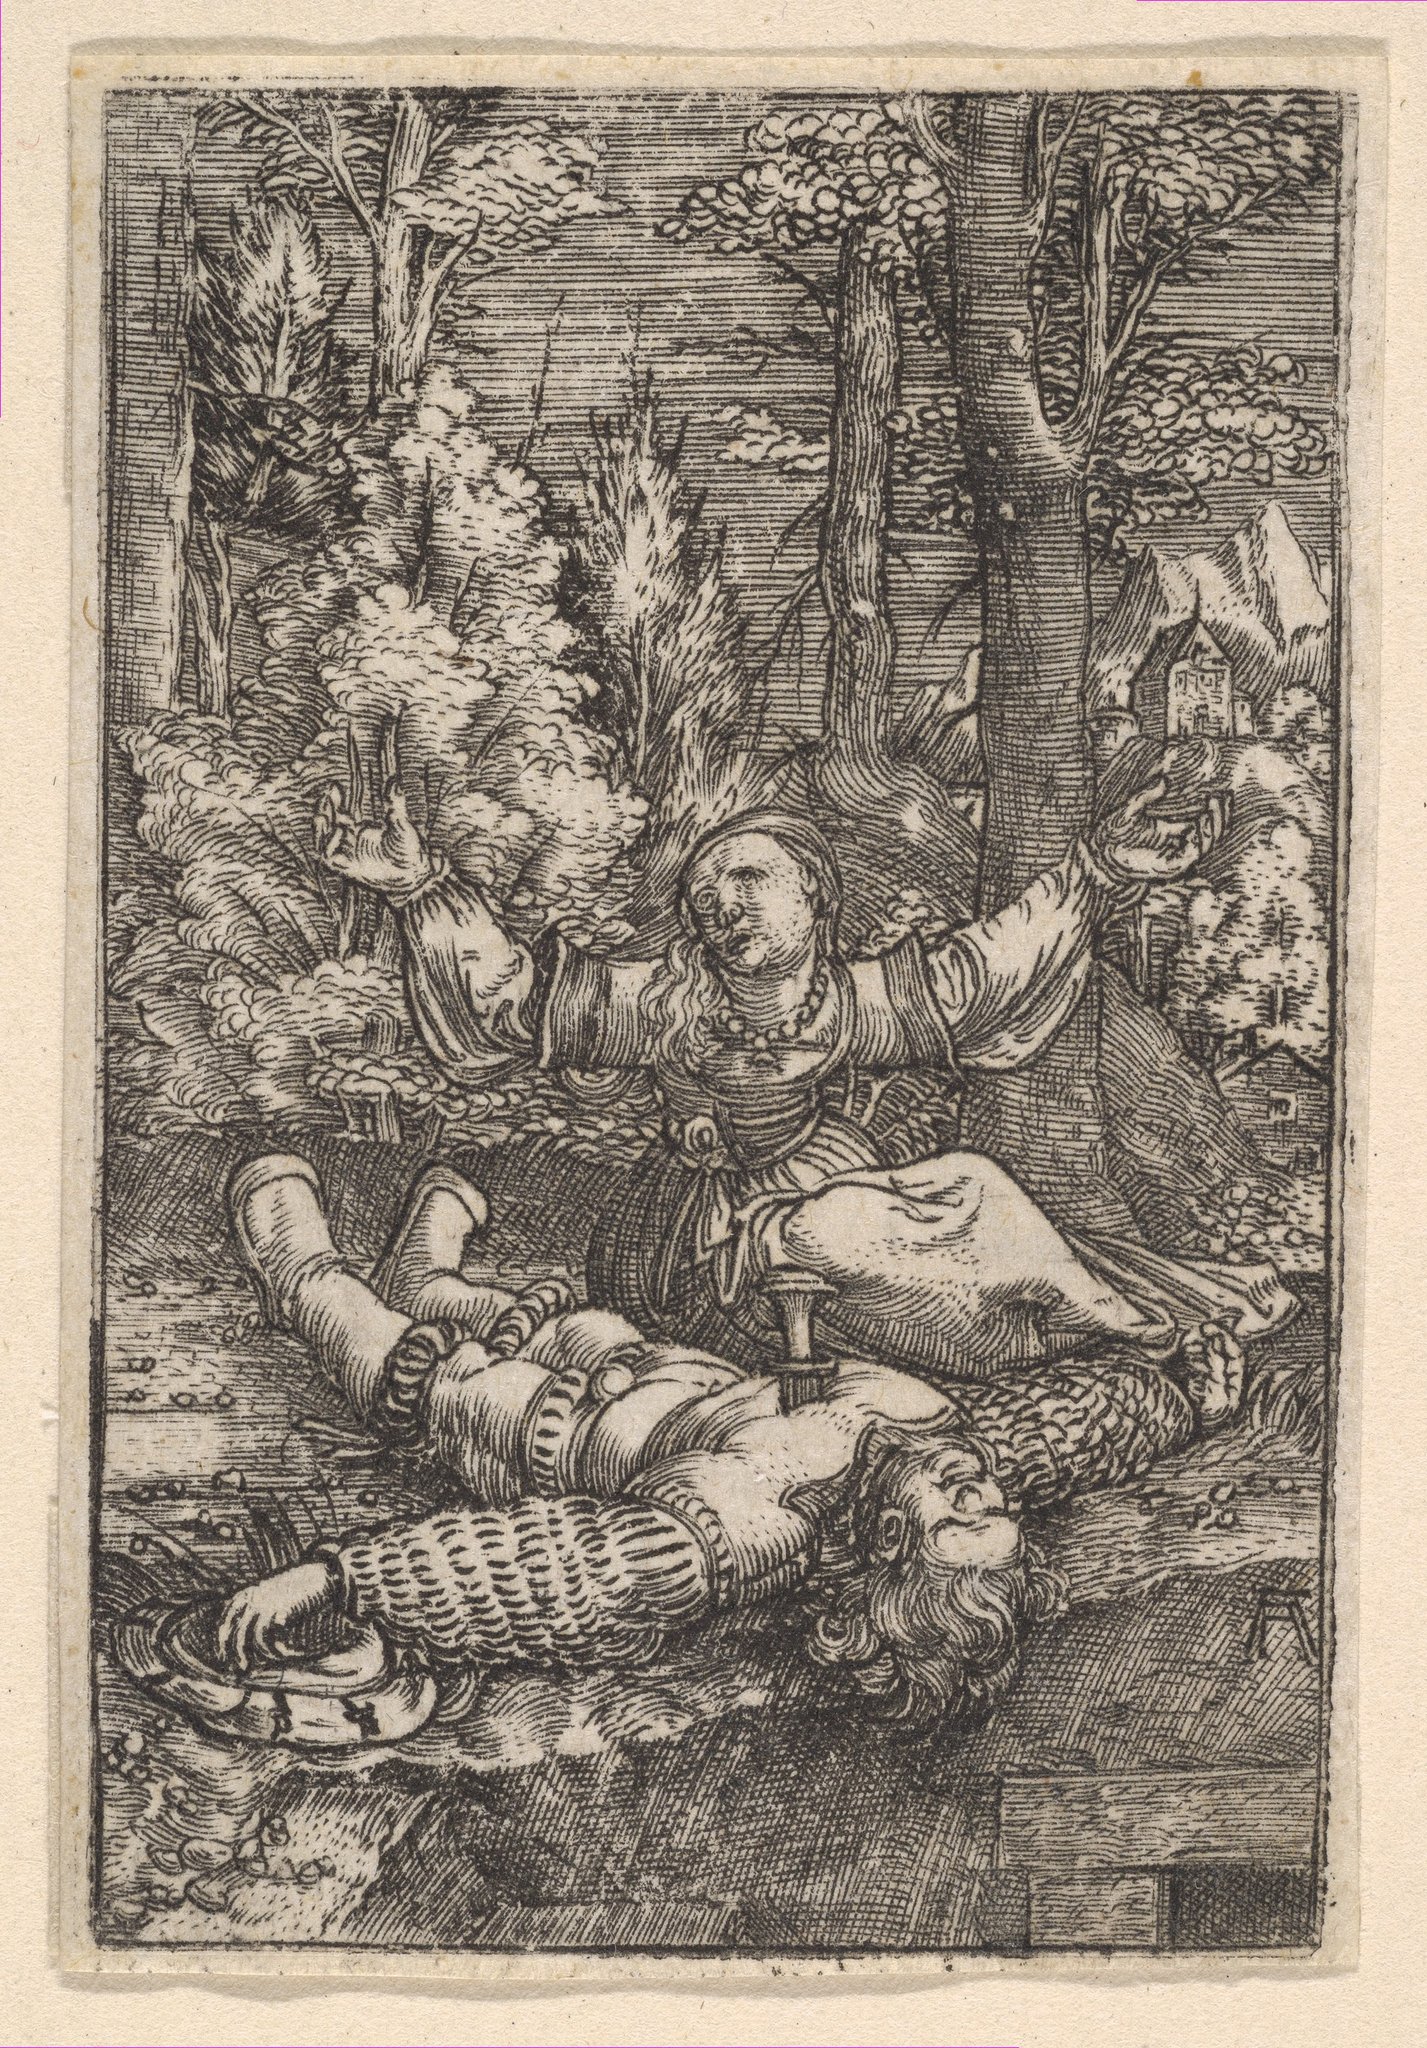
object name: print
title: Pyramus and Thisbe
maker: albrecht altdorfer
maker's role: artist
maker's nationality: german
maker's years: 1480-1538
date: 1500-1538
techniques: engraving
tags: men,women,death